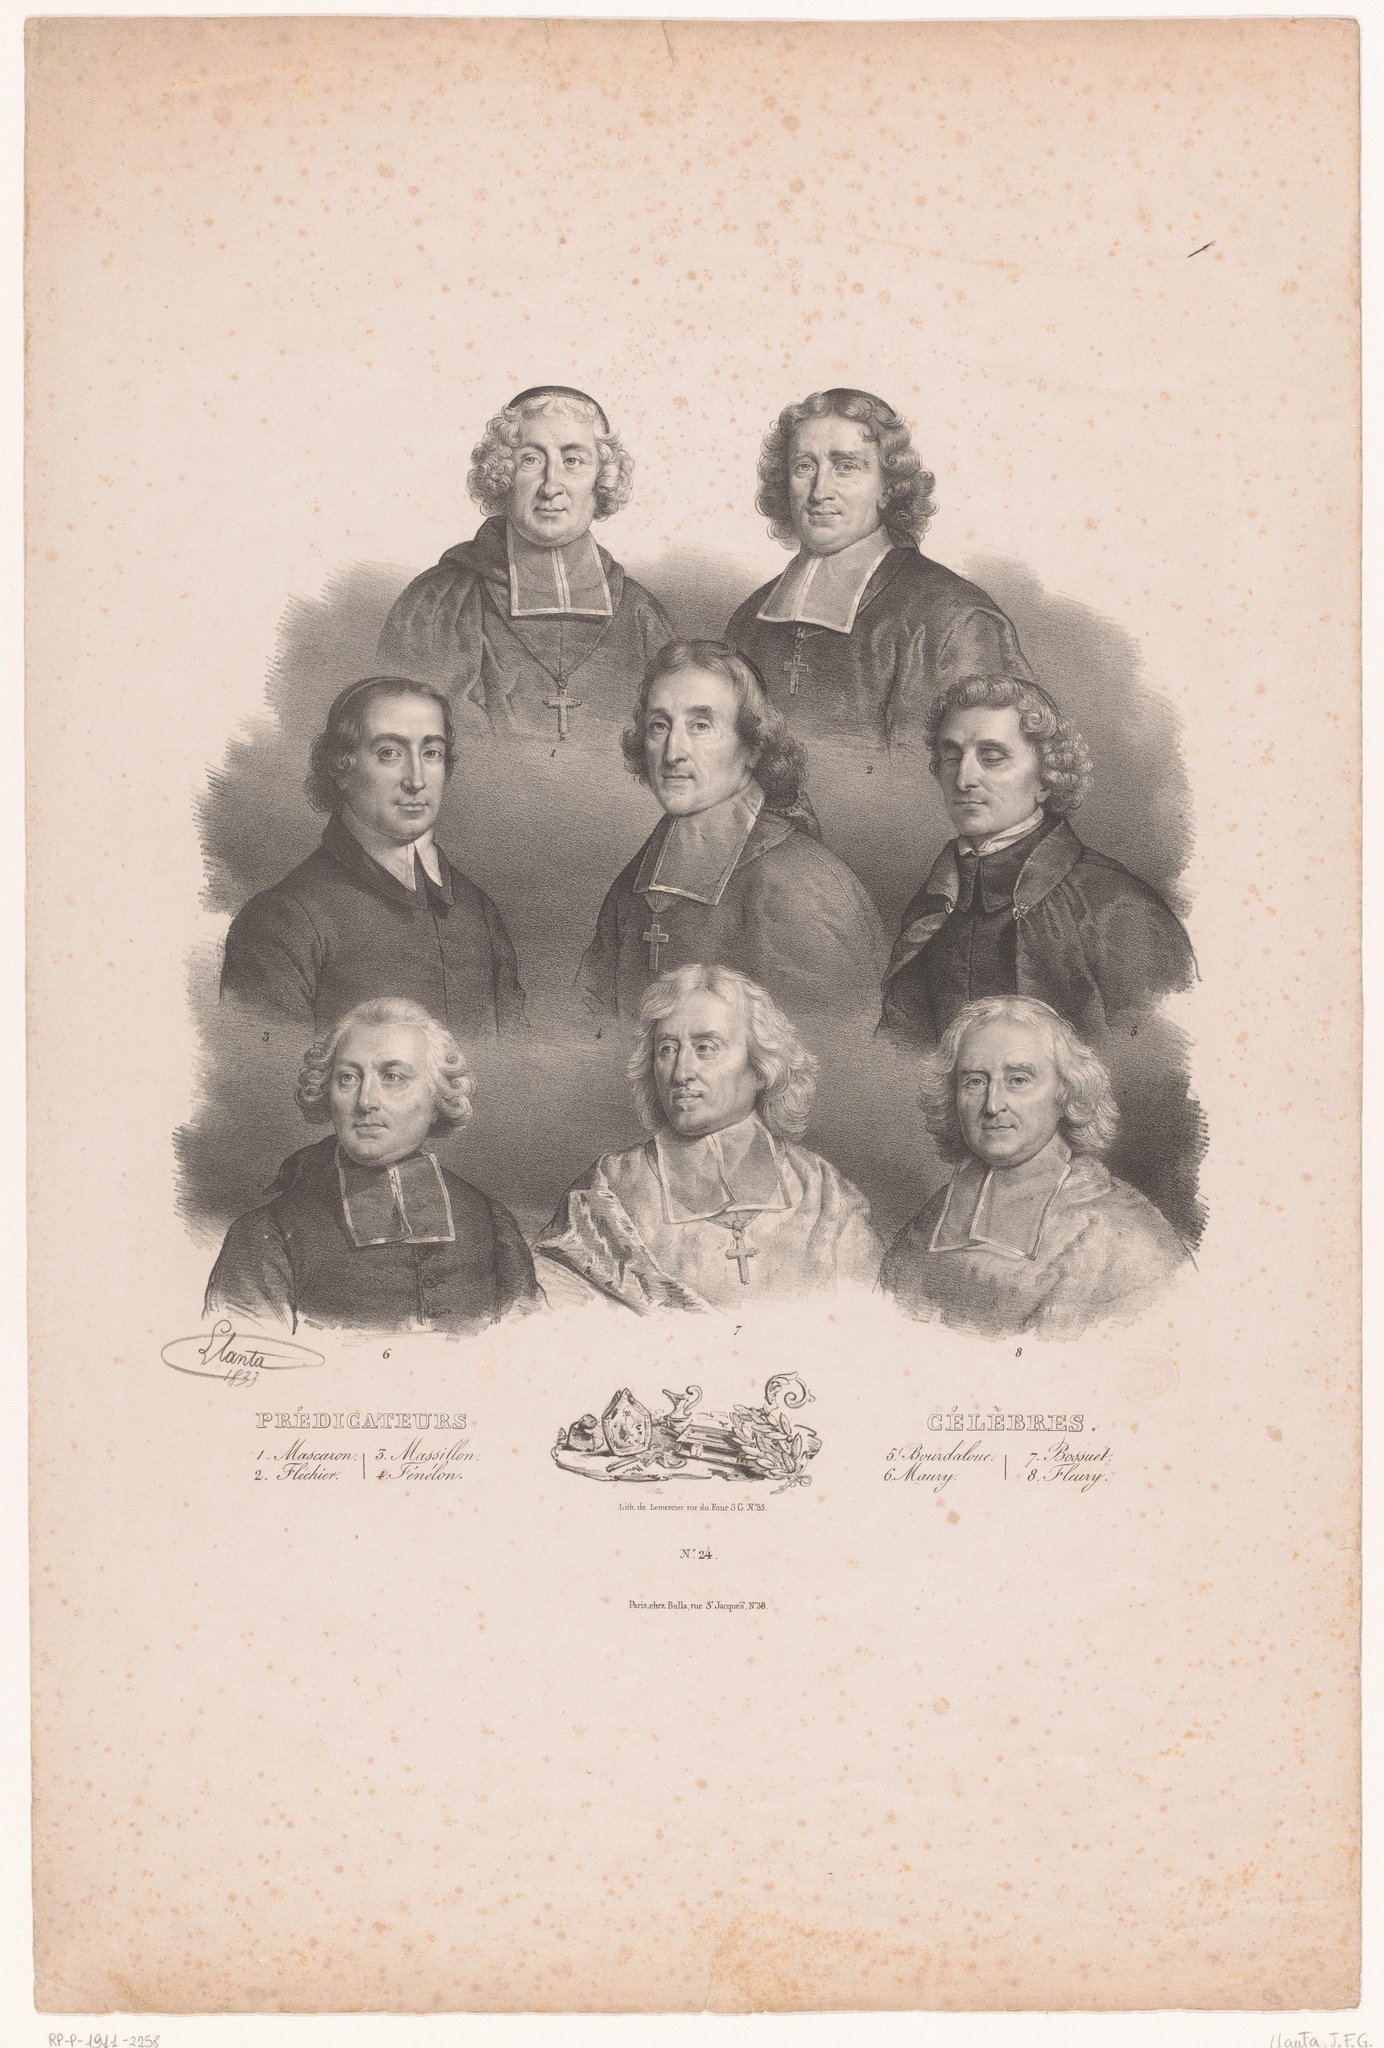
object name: print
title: Portretten van beroemde personen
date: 1833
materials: paper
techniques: lithograph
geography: paris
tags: françois fénelon, france, historical persons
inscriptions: check stamp: Lugt 4088, collector's mark: Lugt 2228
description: Portretten van predikers met een genummerde lijst: 1. Jules Mascaron, 2. Esprit Flécier, 3. Jean-Baptiste Massillon, 4. François Fénelon, 5. Louis Bourdaloue, 6. Jean Sifrein Maury, 7. Jacques Bénigne Bossuet, 8. André-Hercule de Fleury.